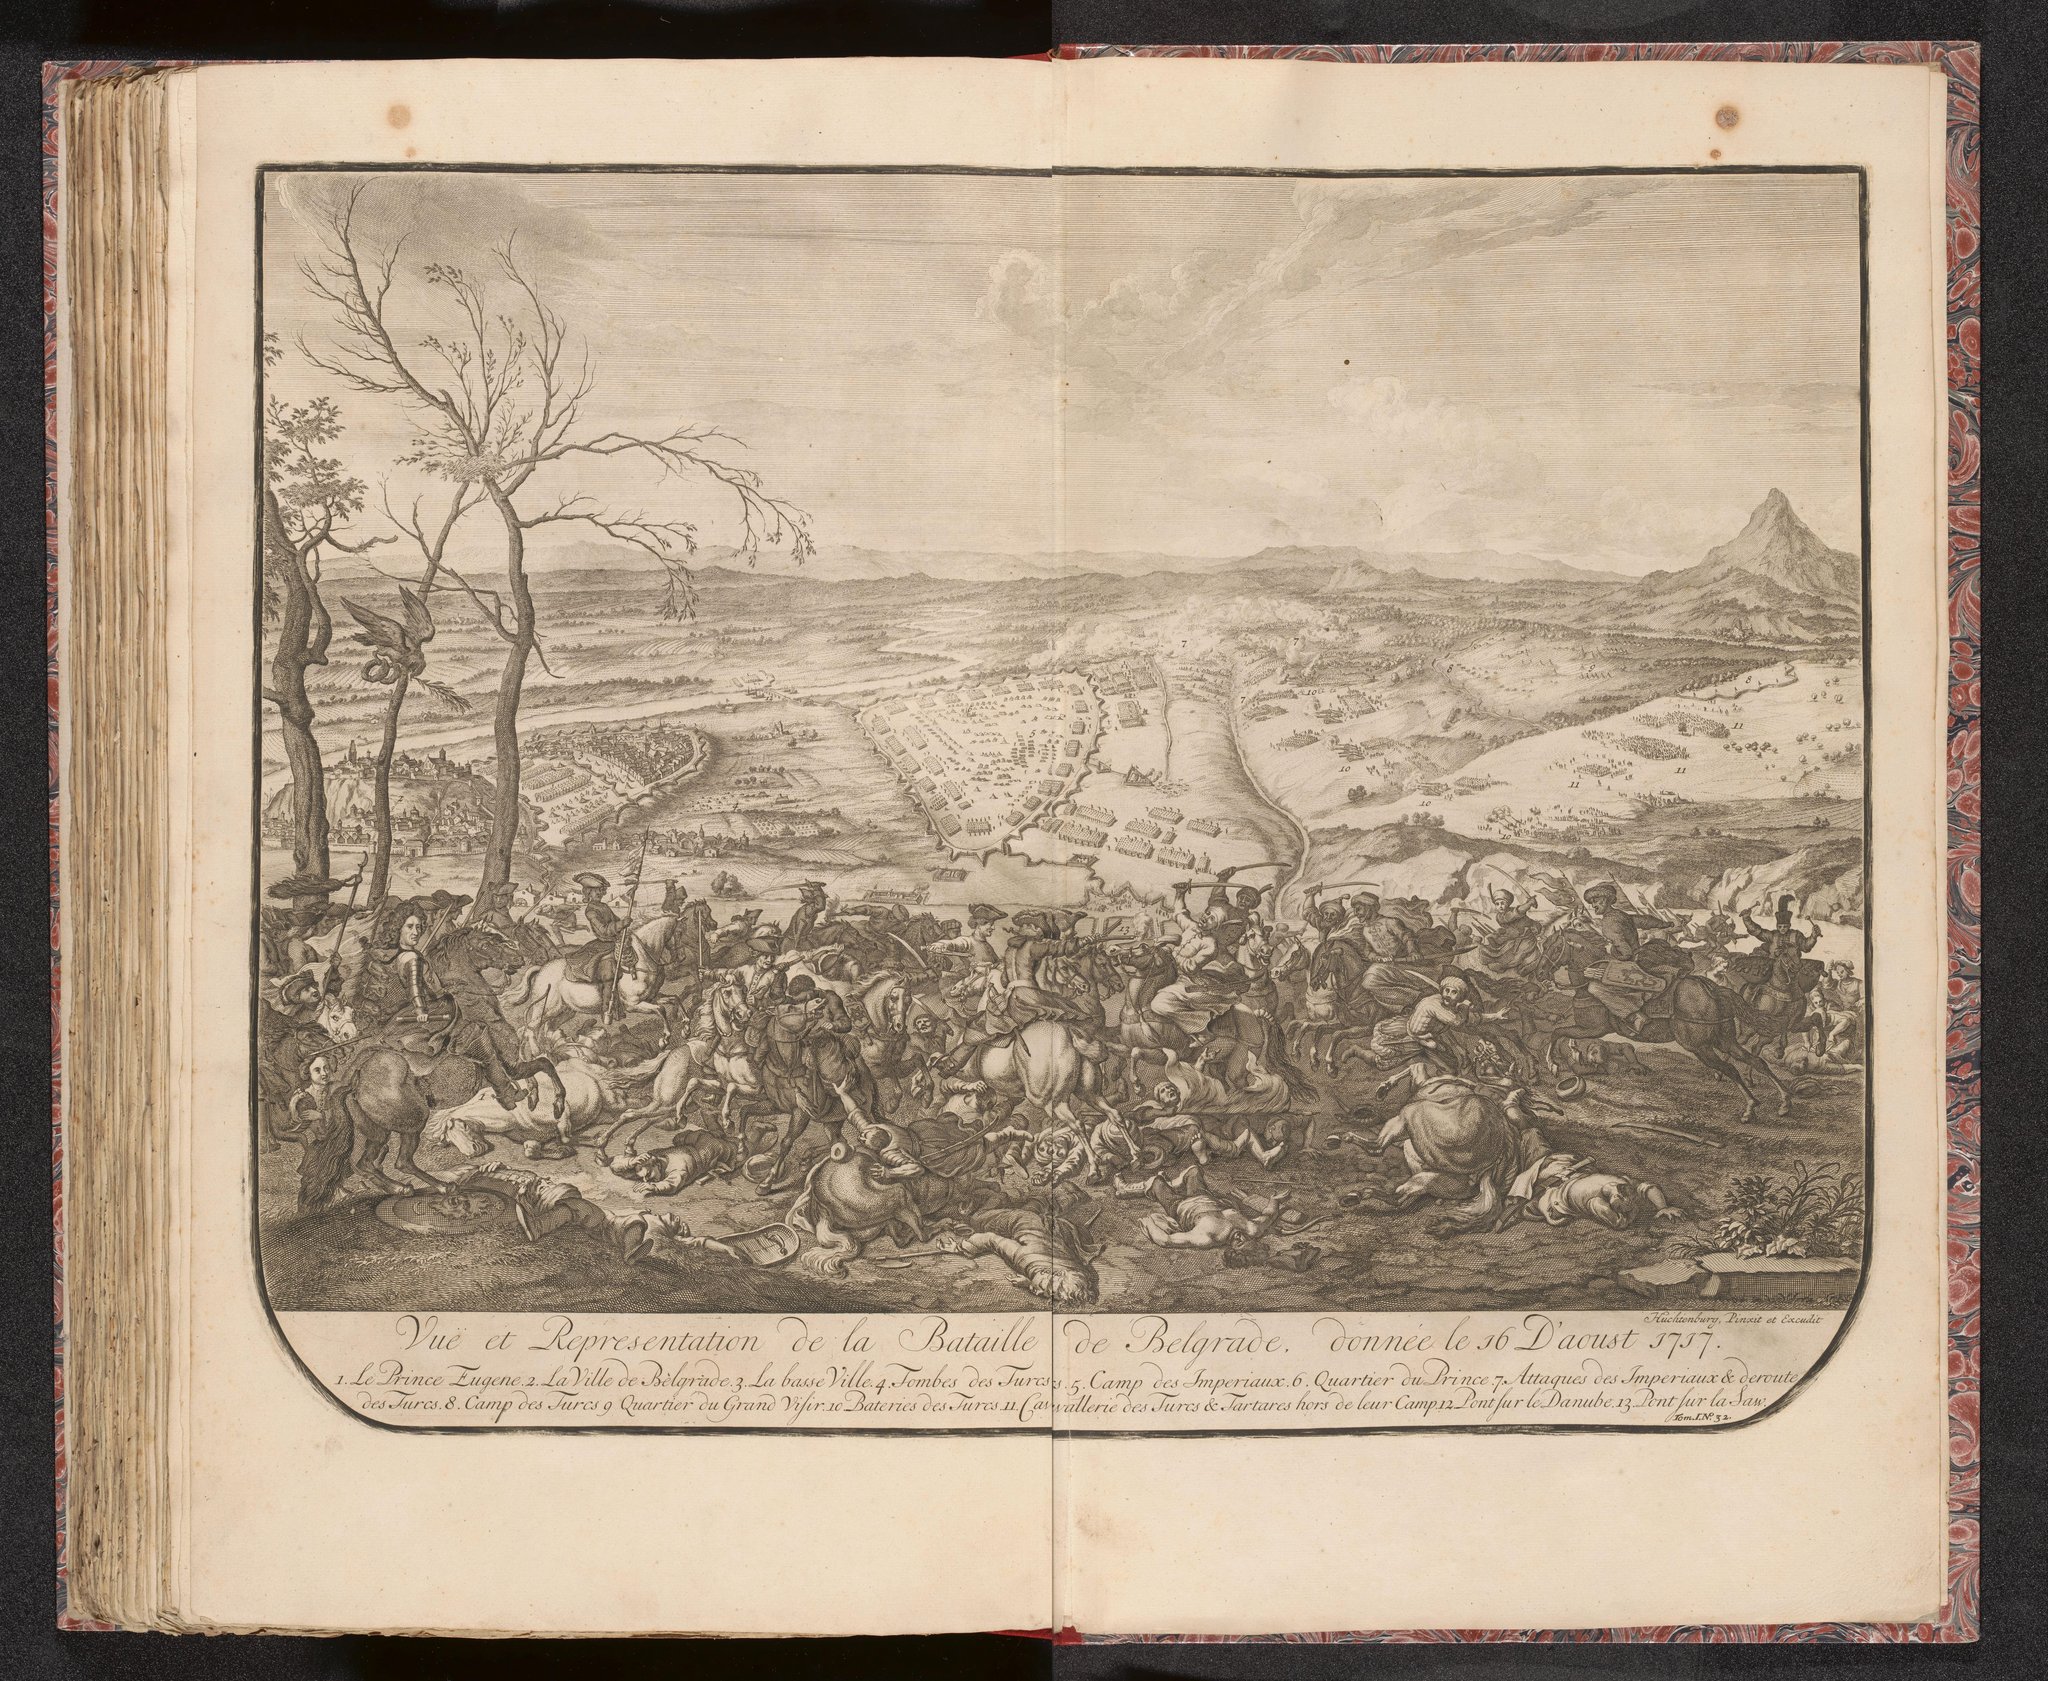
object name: print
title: Vuë et Representation de la Bataille de Belgrade, donnée le 16 D'aoust 1717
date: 1727-1729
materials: paper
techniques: engraving, etching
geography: northern netherlands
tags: paris, vienna, eugenius van savoye, battle (+ land forces)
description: Veldslag bij de verovering van de stad Belgrado door de keizerlijke troepen onder de prins van Savoye op de Turken, 16 augustus 1717. Linksvoor de prins te paard. Genummerd rechtsonder: Tom. I. No. 32. Illustratie in het eerste deel van: Jean du Mont, Oorlogskundige beschryving van de veldslagen en belegeringen, der drie ... wydvermaarde krygsoversten... den Prins Eugenius van Savoye, den ... Hertog van Marlborough, en den Prins van Oranje en Nassau-Vriesland, in de editie van 1729. Dit eerste deel is gewijd aan de daden van Eugenius, prins van Savoye.